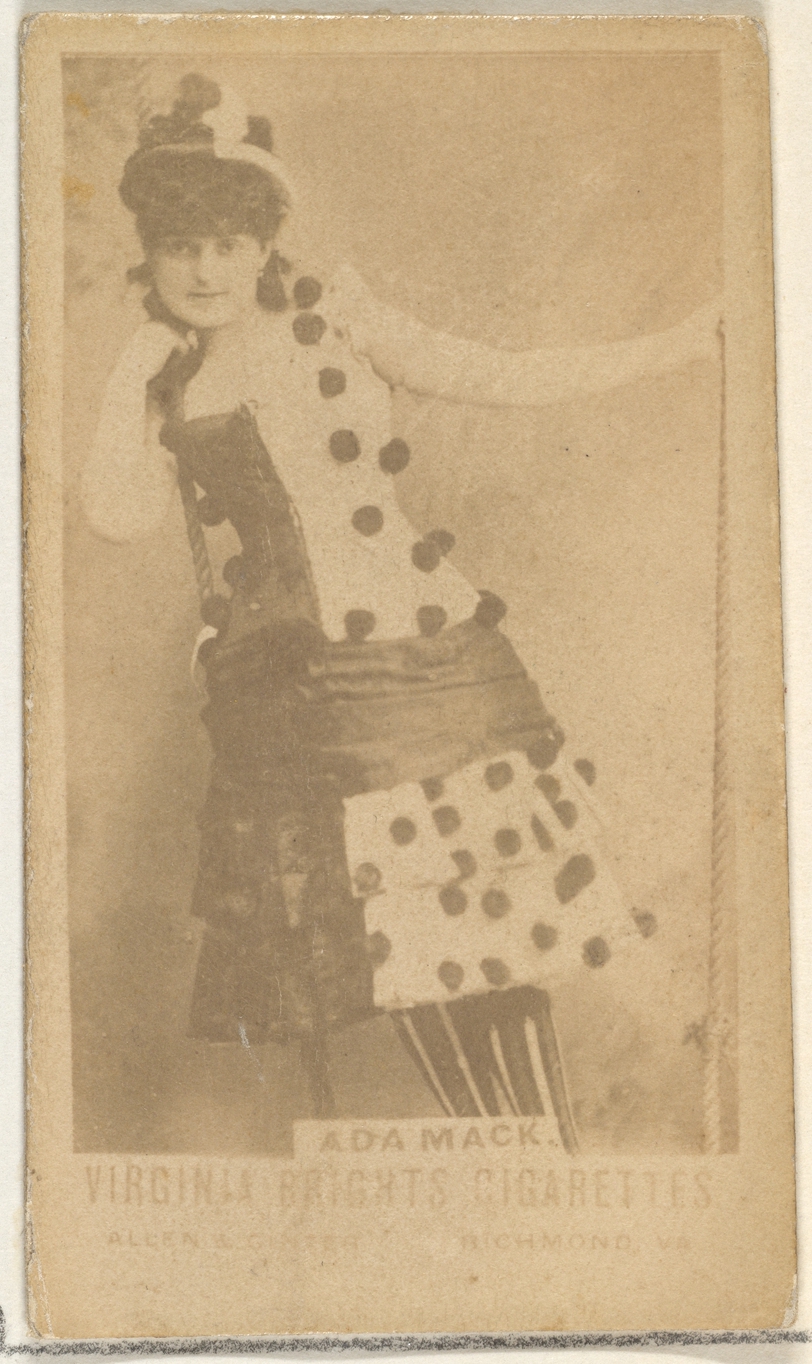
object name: photograph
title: Ada Mack, from the Actors and Actresses series (N45, Type 1) for Virginia Brights Cigarettes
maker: allen & ginter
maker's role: publisher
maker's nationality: american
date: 1888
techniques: albumen silver print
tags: portraits,women,actresses